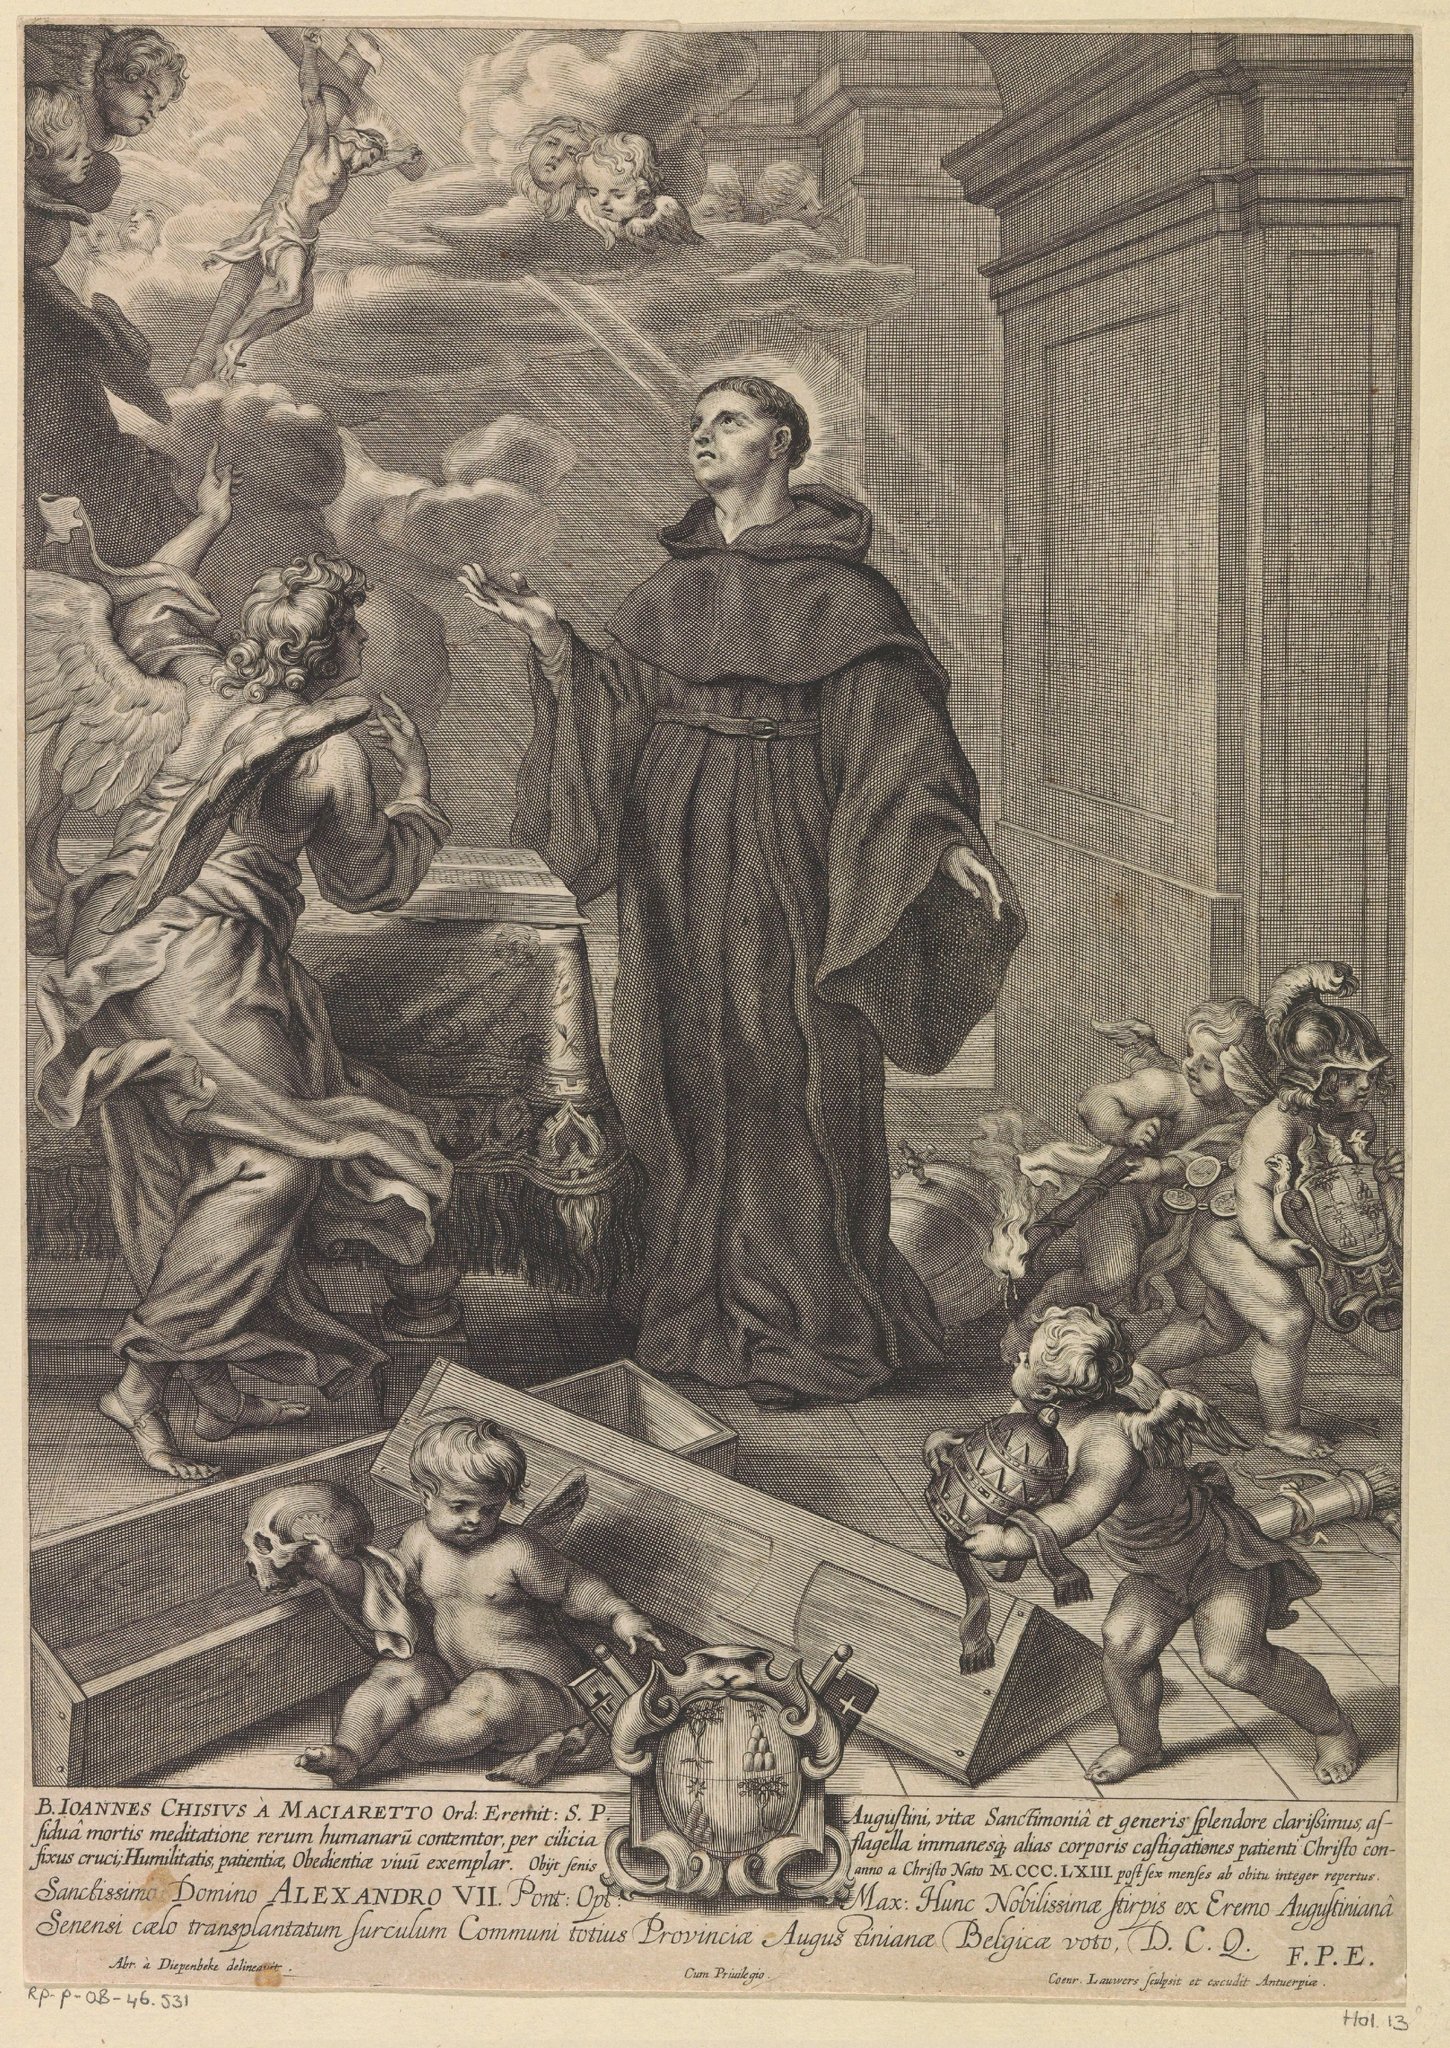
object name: print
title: Visioen van Joannes Chisius van Maciaretto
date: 1642-1685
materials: paper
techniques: engraving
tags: vision, the crucifixion of christ: christ's death on the cross; golgotha (matthew 27:45-58; mark 15:33-45; luke 23:44-52; john 19:25-38)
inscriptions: collector's mark: Lugt 240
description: Visioen van de geestelijke Joannes Chisius van Maciaretto. Een engel wijst hem op de gekruisigde Christus die in de wolken is verschenen. Op de voorgrond zit een putto bij een open doodskist met een doodshoofd in zijn handen, de putto rechts houdt een kroon vast. Op de achtergrond lopen twee putti met het wapenschild van paus Alexander VII en een brandende toorts. In de marge hetzelfde wapenschild en een vijfregelige tekst in Latijn.